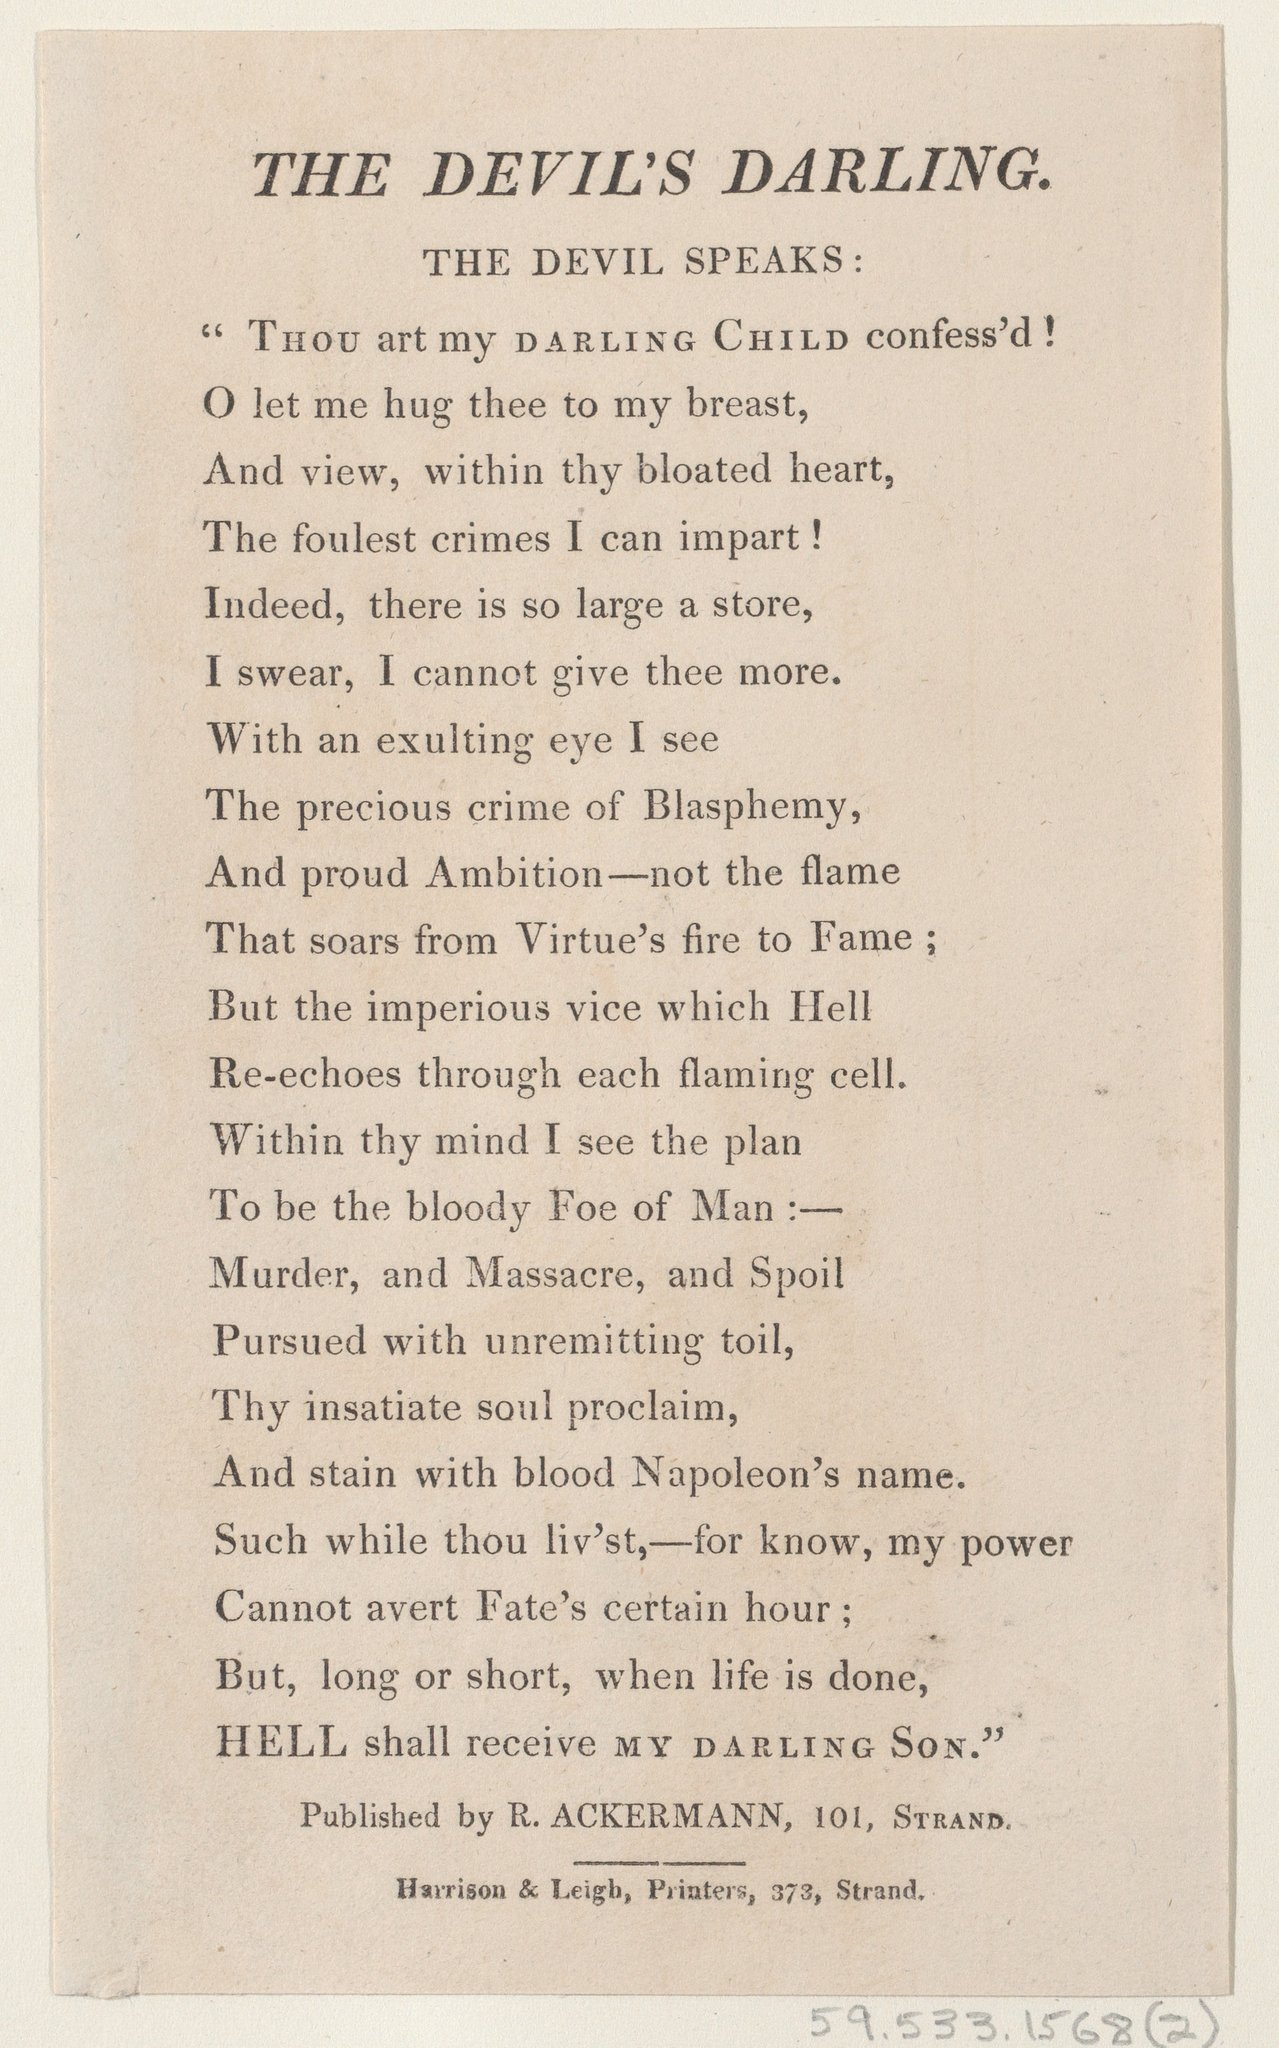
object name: print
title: The Devil's Darling: Text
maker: rudolph ackermann, london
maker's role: publisher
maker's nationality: british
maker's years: 1794-1832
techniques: letterpress